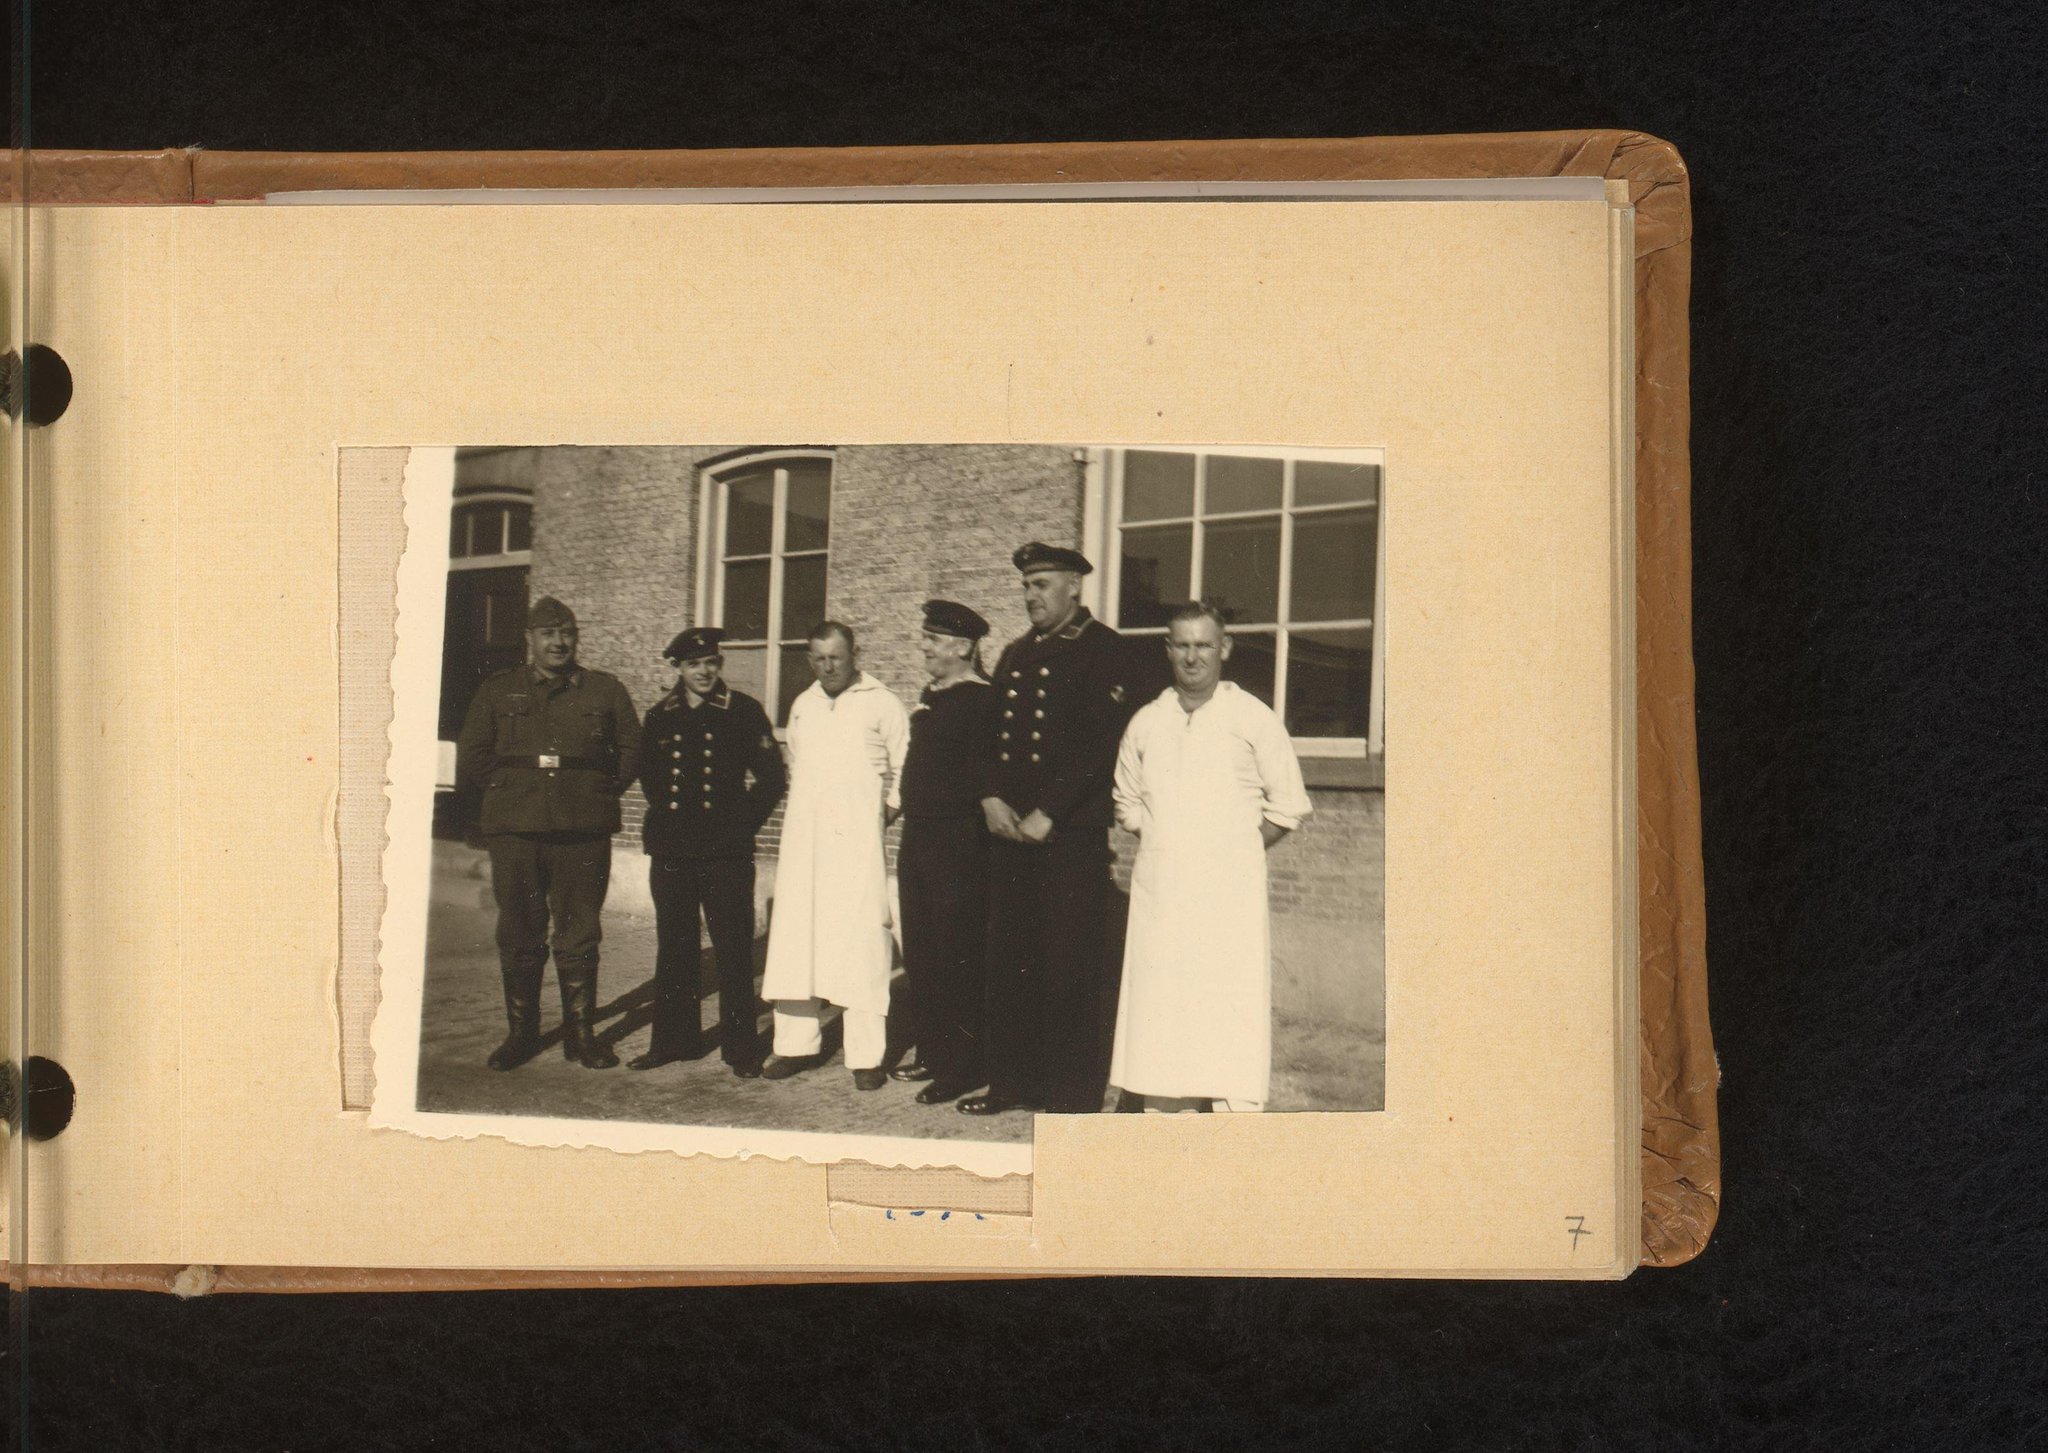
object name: album leaf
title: Staande militairen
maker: Anonymous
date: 1940-1943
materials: paper, photographic support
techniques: gelatin silver print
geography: netherlands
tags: the company, the unit, the troop ~ military service, shelter ~ military service, occupation ~ war, netherlands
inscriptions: inscription: ‘Unser ... aus "Italien" / Maschinen .. aus Kiel / ... Oberkoch’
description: Albumblad met een foto van zes militairen van de Kriegsmarine staande voor een gebouw. Onderdeel van een klein album van de Kriegsmarine in Nederland.